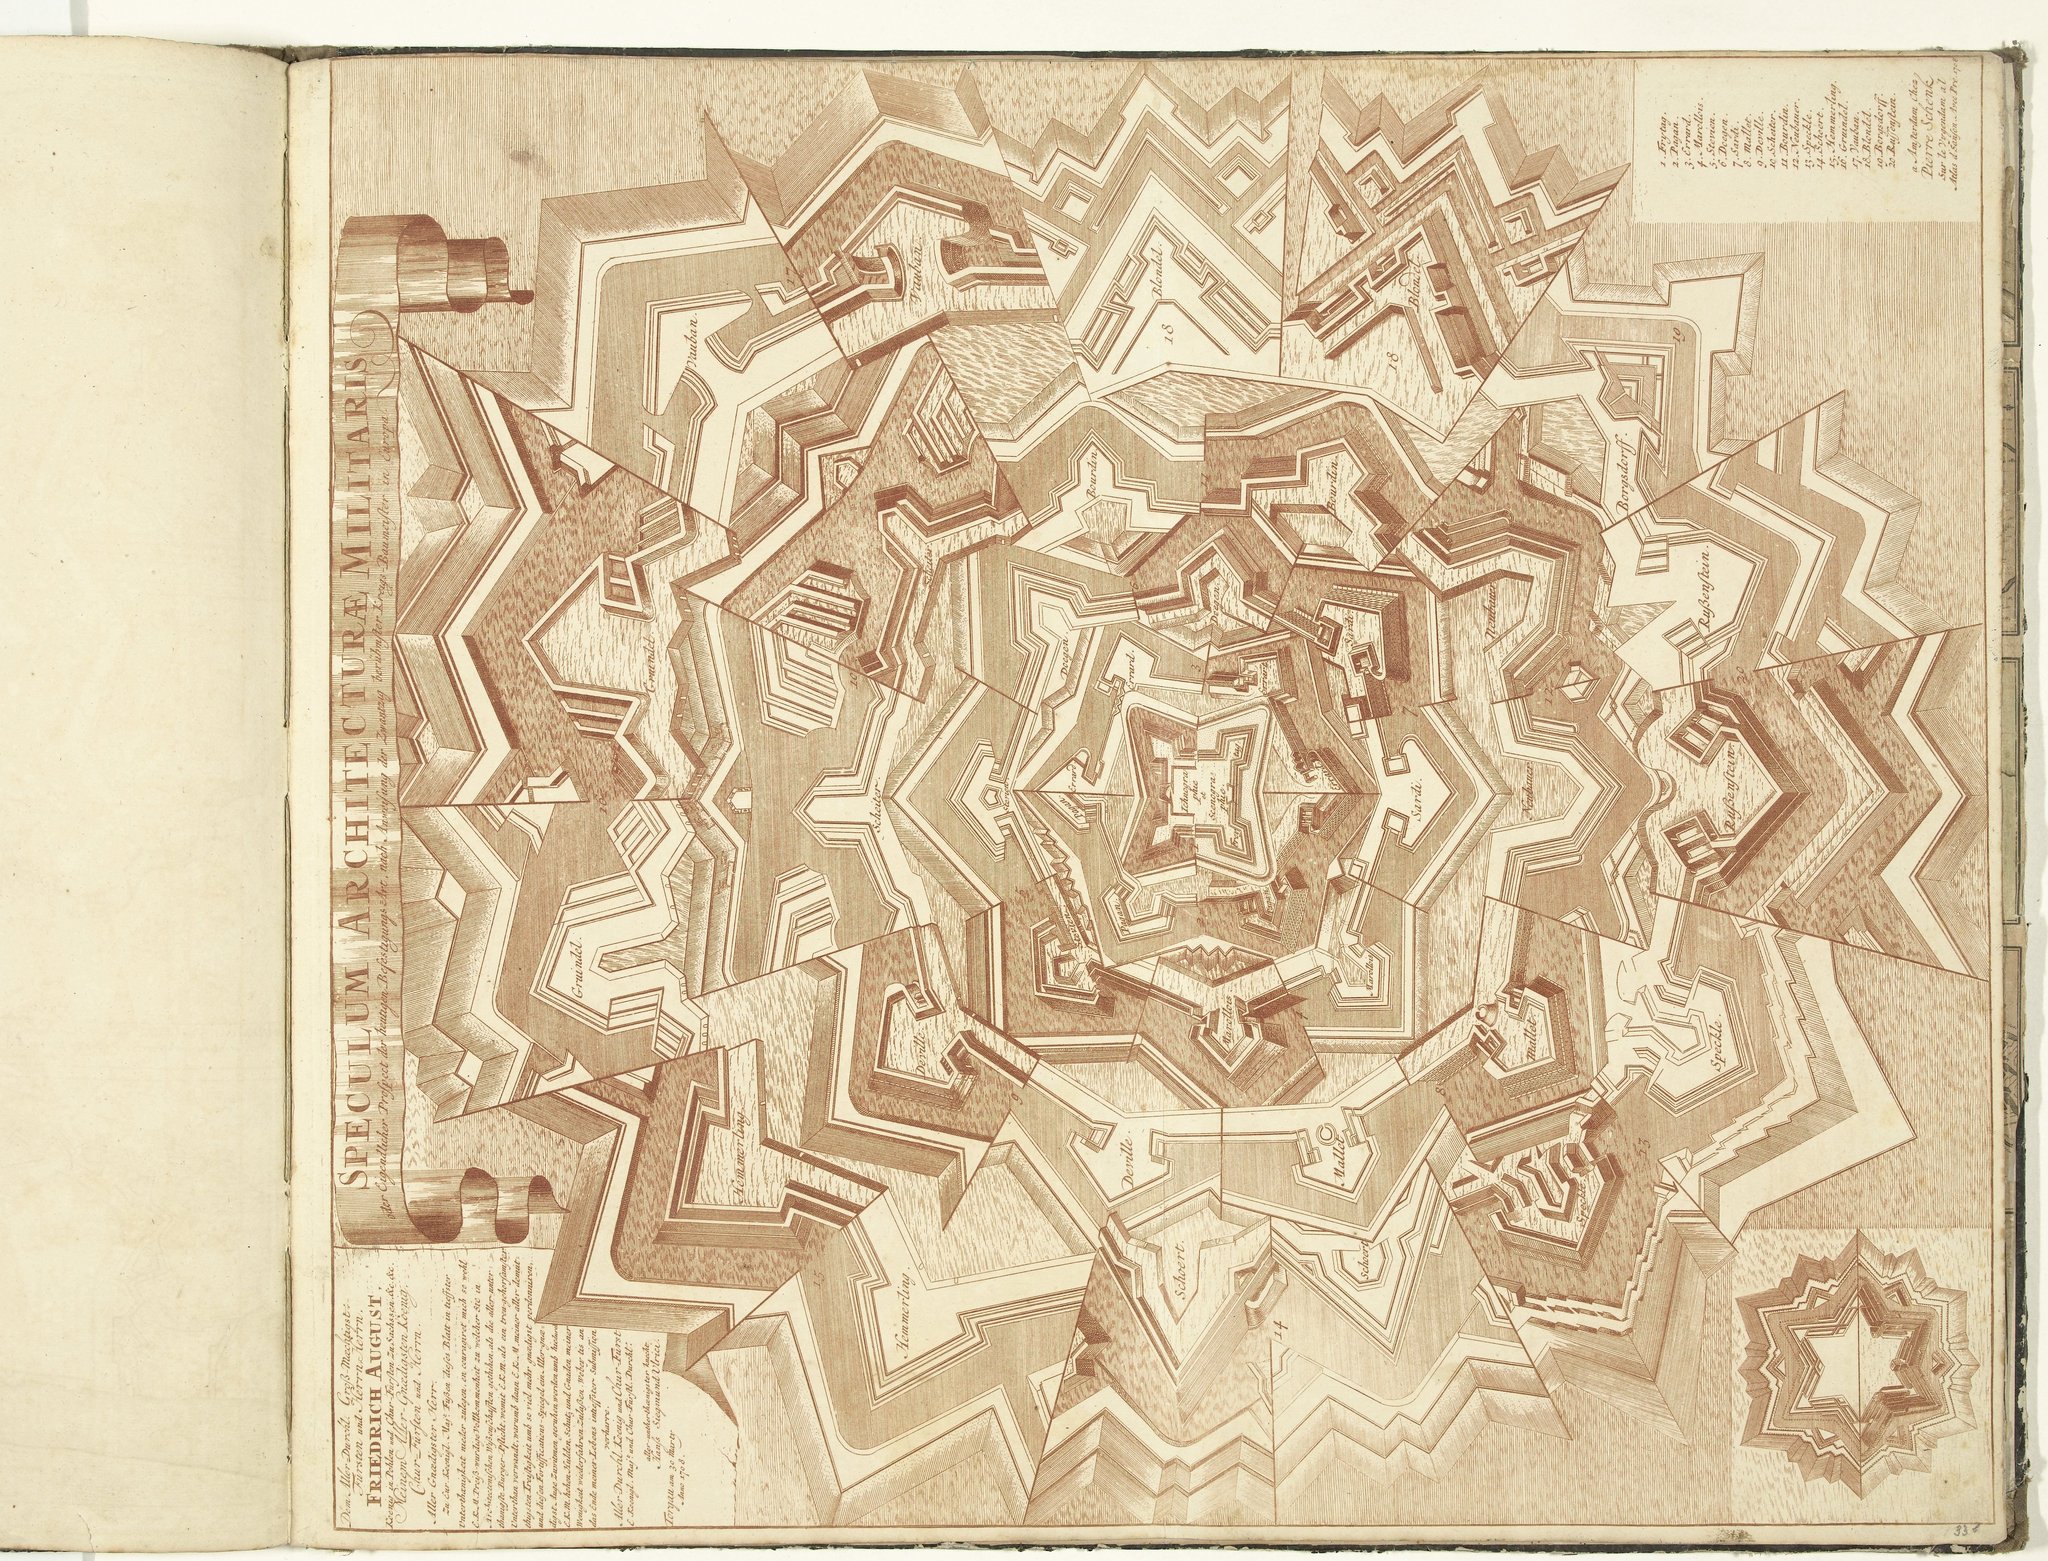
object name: print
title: Schouwburg van den oorlog (blad XXXIII), 1708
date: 1708-1710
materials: paper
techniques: etching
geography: amsterdam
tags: fortress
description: Blad met een samengestelde compositie opgebouwd uit twintig punten van militaire vestingtypen, 1708. In elk punt de naam van de militaire ingenieur die de bastion heeft ontworpen. Blad XXXIII in: Schouwburg van den oorlog (editie van 1709), het prentwerk met de gebundelde reeks van 18 platen over de Spaanse Successieoorlog.